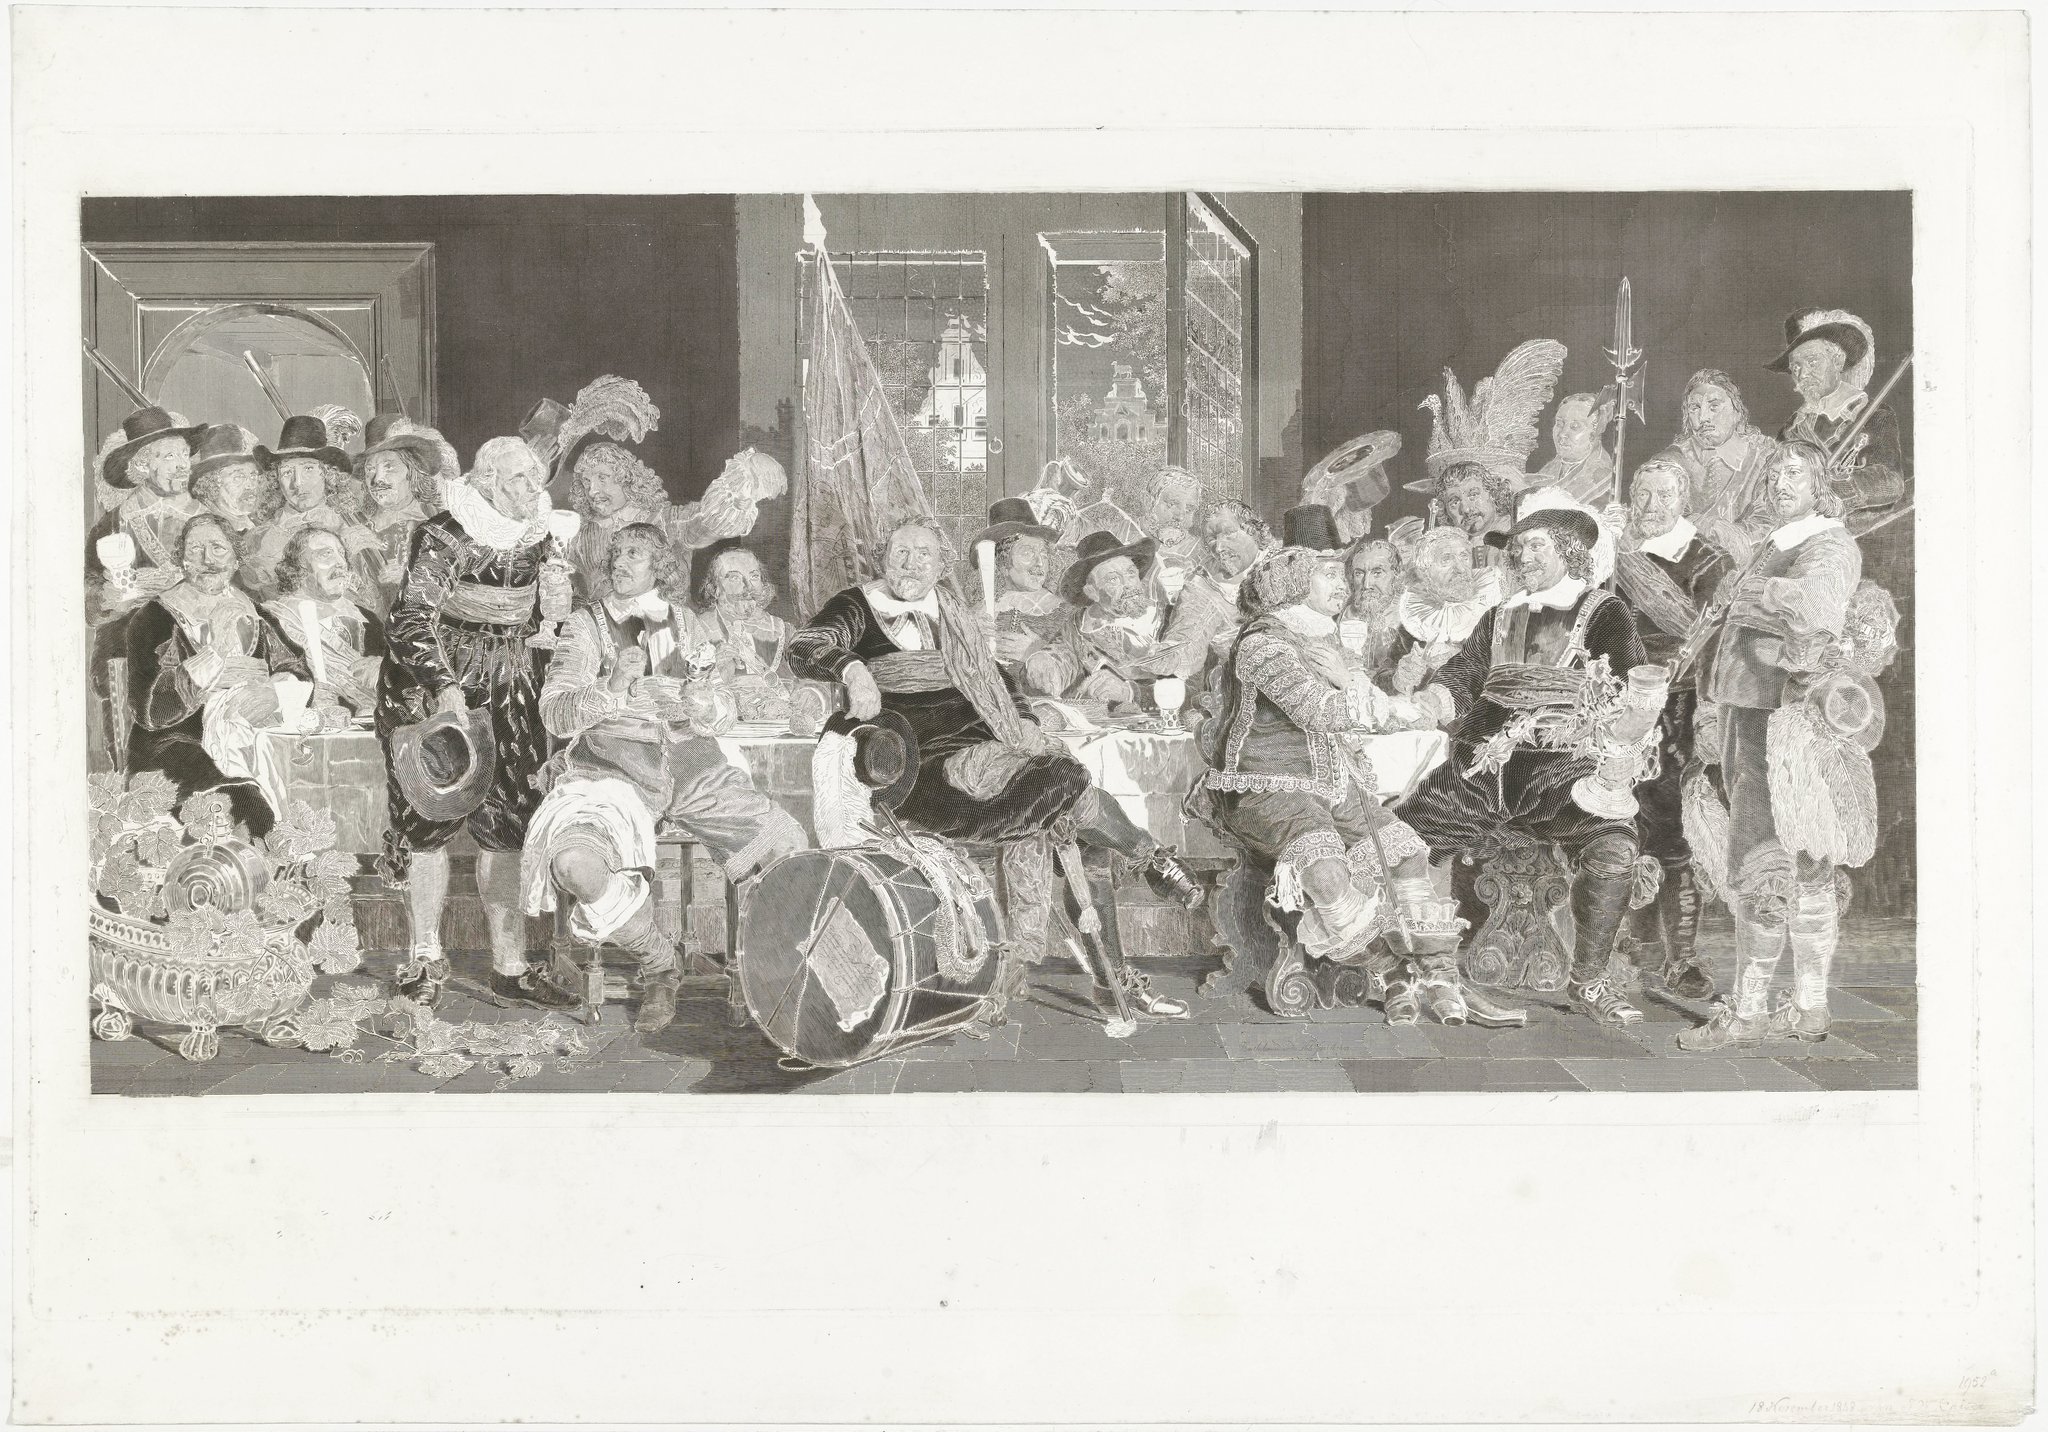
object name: print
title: De schuttersmaaltijd in de Voetboog- of St. Jorisdoelen te Amsterdam ter viering van het sluiten van de vrede van Munster, 18 juni 1648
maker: henricus wilhelmus couwenberg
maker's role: draughtsman, print maker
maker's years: 1814-1845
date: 1848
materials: paper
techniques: engraving, etching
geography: netherlands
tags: warfare; military affairs (+ citizen soldiery, civil guard, citizen militia), celebration meal, feast, banquet, festivities on events of national importance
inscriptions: annotation: ‘18 November 1848 van J.W. Kaiser’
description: Het schilderij van de schuttersmaaltijd in de Voetboogdoelen of St. Jorisdoelen te Amsterdam ter viering van het sluiten van de vrede van Munster, 18 juni 1648. Voorgesteld zijn: kapitein Cornelis Jansz Witsen (met de zilveren drinkhoorn), luitenant Johan Oetgens van Waveren (die zijn hand schudt), de vaandrig Jacob Banningh (zittend naast de grote trommel), Dirck Claesz Thoveling en Thomas Hartog (sergeanten), Pieter van Hoorn, Willem Pietersz van der Voort, Adriaen Dirck Sparwer, Hendrick Calaber, Govert van der Mij, Johannes Calaber, Benedictus Schaeck, Jan Maes, Jacob van Diemen, Jan van Ommeren, Isaac Ooyens, Gerrit Pietersz van Anstenraadt, Herman Teunisz de Kluyter, Andries van Anstenraadt, Christoffel Poock, Hendrick Dommer Wz, Paulus Hennekijn, Lambregt van den Bos en Willem (de trommelslager). Op de grote trommel hangt een papier met een gedicht van Jan Vos. Door de openstaande ramen is de gevel van de brouwerij 'het Lam' aan de Singel zichtbaar. Rechts brengt een vrouwen een kalkoenpastei binnen. Op tafel staan tinnen borden, roemers en andere glazen. Links staat op de vloer een grote metalen koeler met een wijnvat.